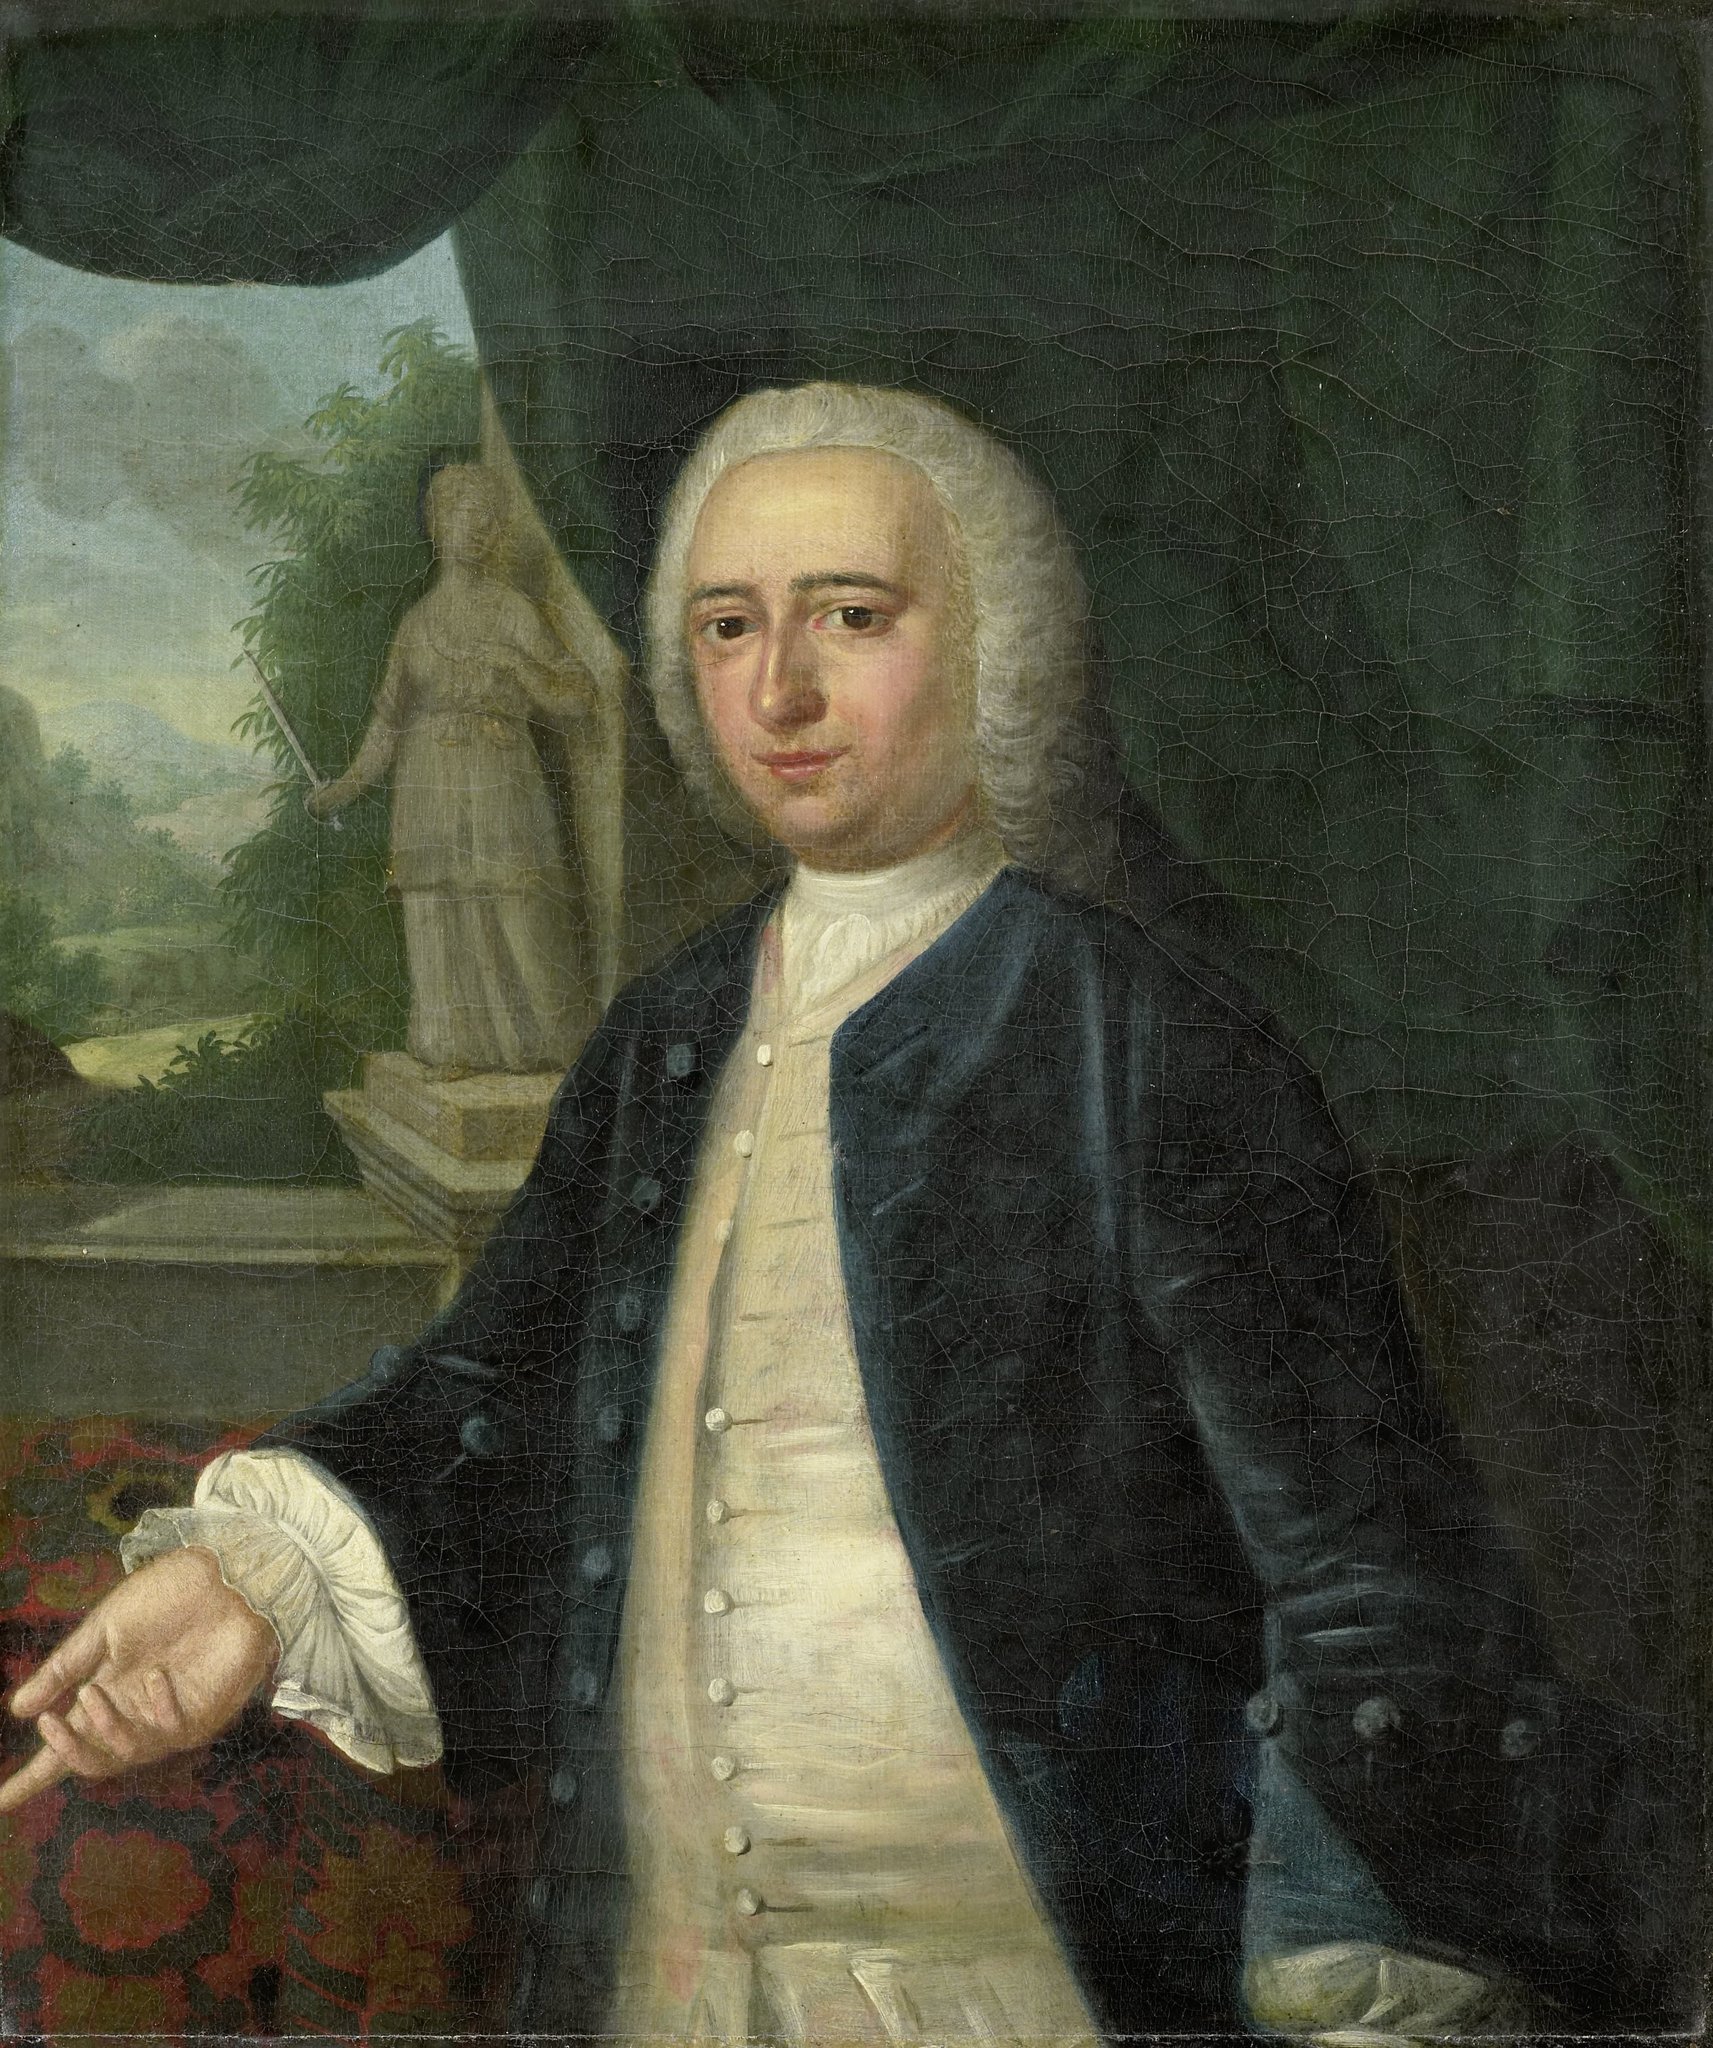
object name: painting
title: Portrait of Johan Willem Parker, Lord of Saamslag, Geersdijk, Wissekerke, Cats and Soelekerke, Burgomaster of Middelburg, Deputy of Walcheren in Zeeland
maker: jacob jan nachenius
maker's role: painter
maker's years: 1709-1752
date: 1746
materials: canvas, oil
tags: middelburg, the hague, mayor, historical persons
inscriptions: signature and date: ‘J.J. Nachenius Fecit 1746’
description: Portret van Johan Willem Parker, heer van Saamslag, Geersdijk, Wissekerke, Cats en Soelekerke. Burgemeester van Middelburg, gedeputeerde voor Walcheren in de Staten van Zeeland. Staande, ten halven lijve voor een balustrade met een beeld van Justitia. Pendant van SK-A-1657.